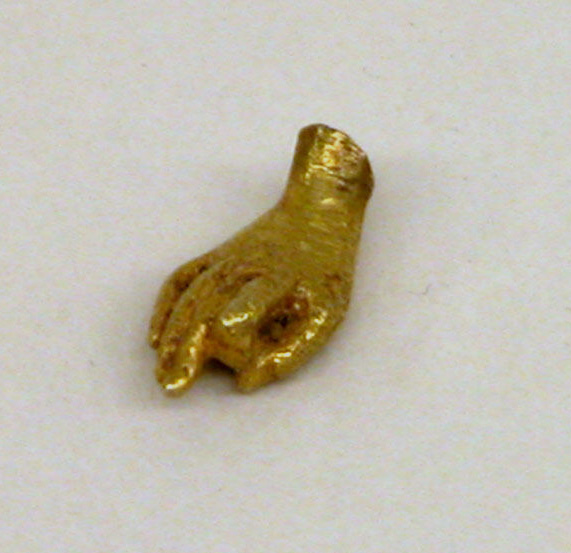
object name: ornament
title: Minature Hand in Vitarka Mudra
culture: indonesian, javanese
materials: gold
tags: hands